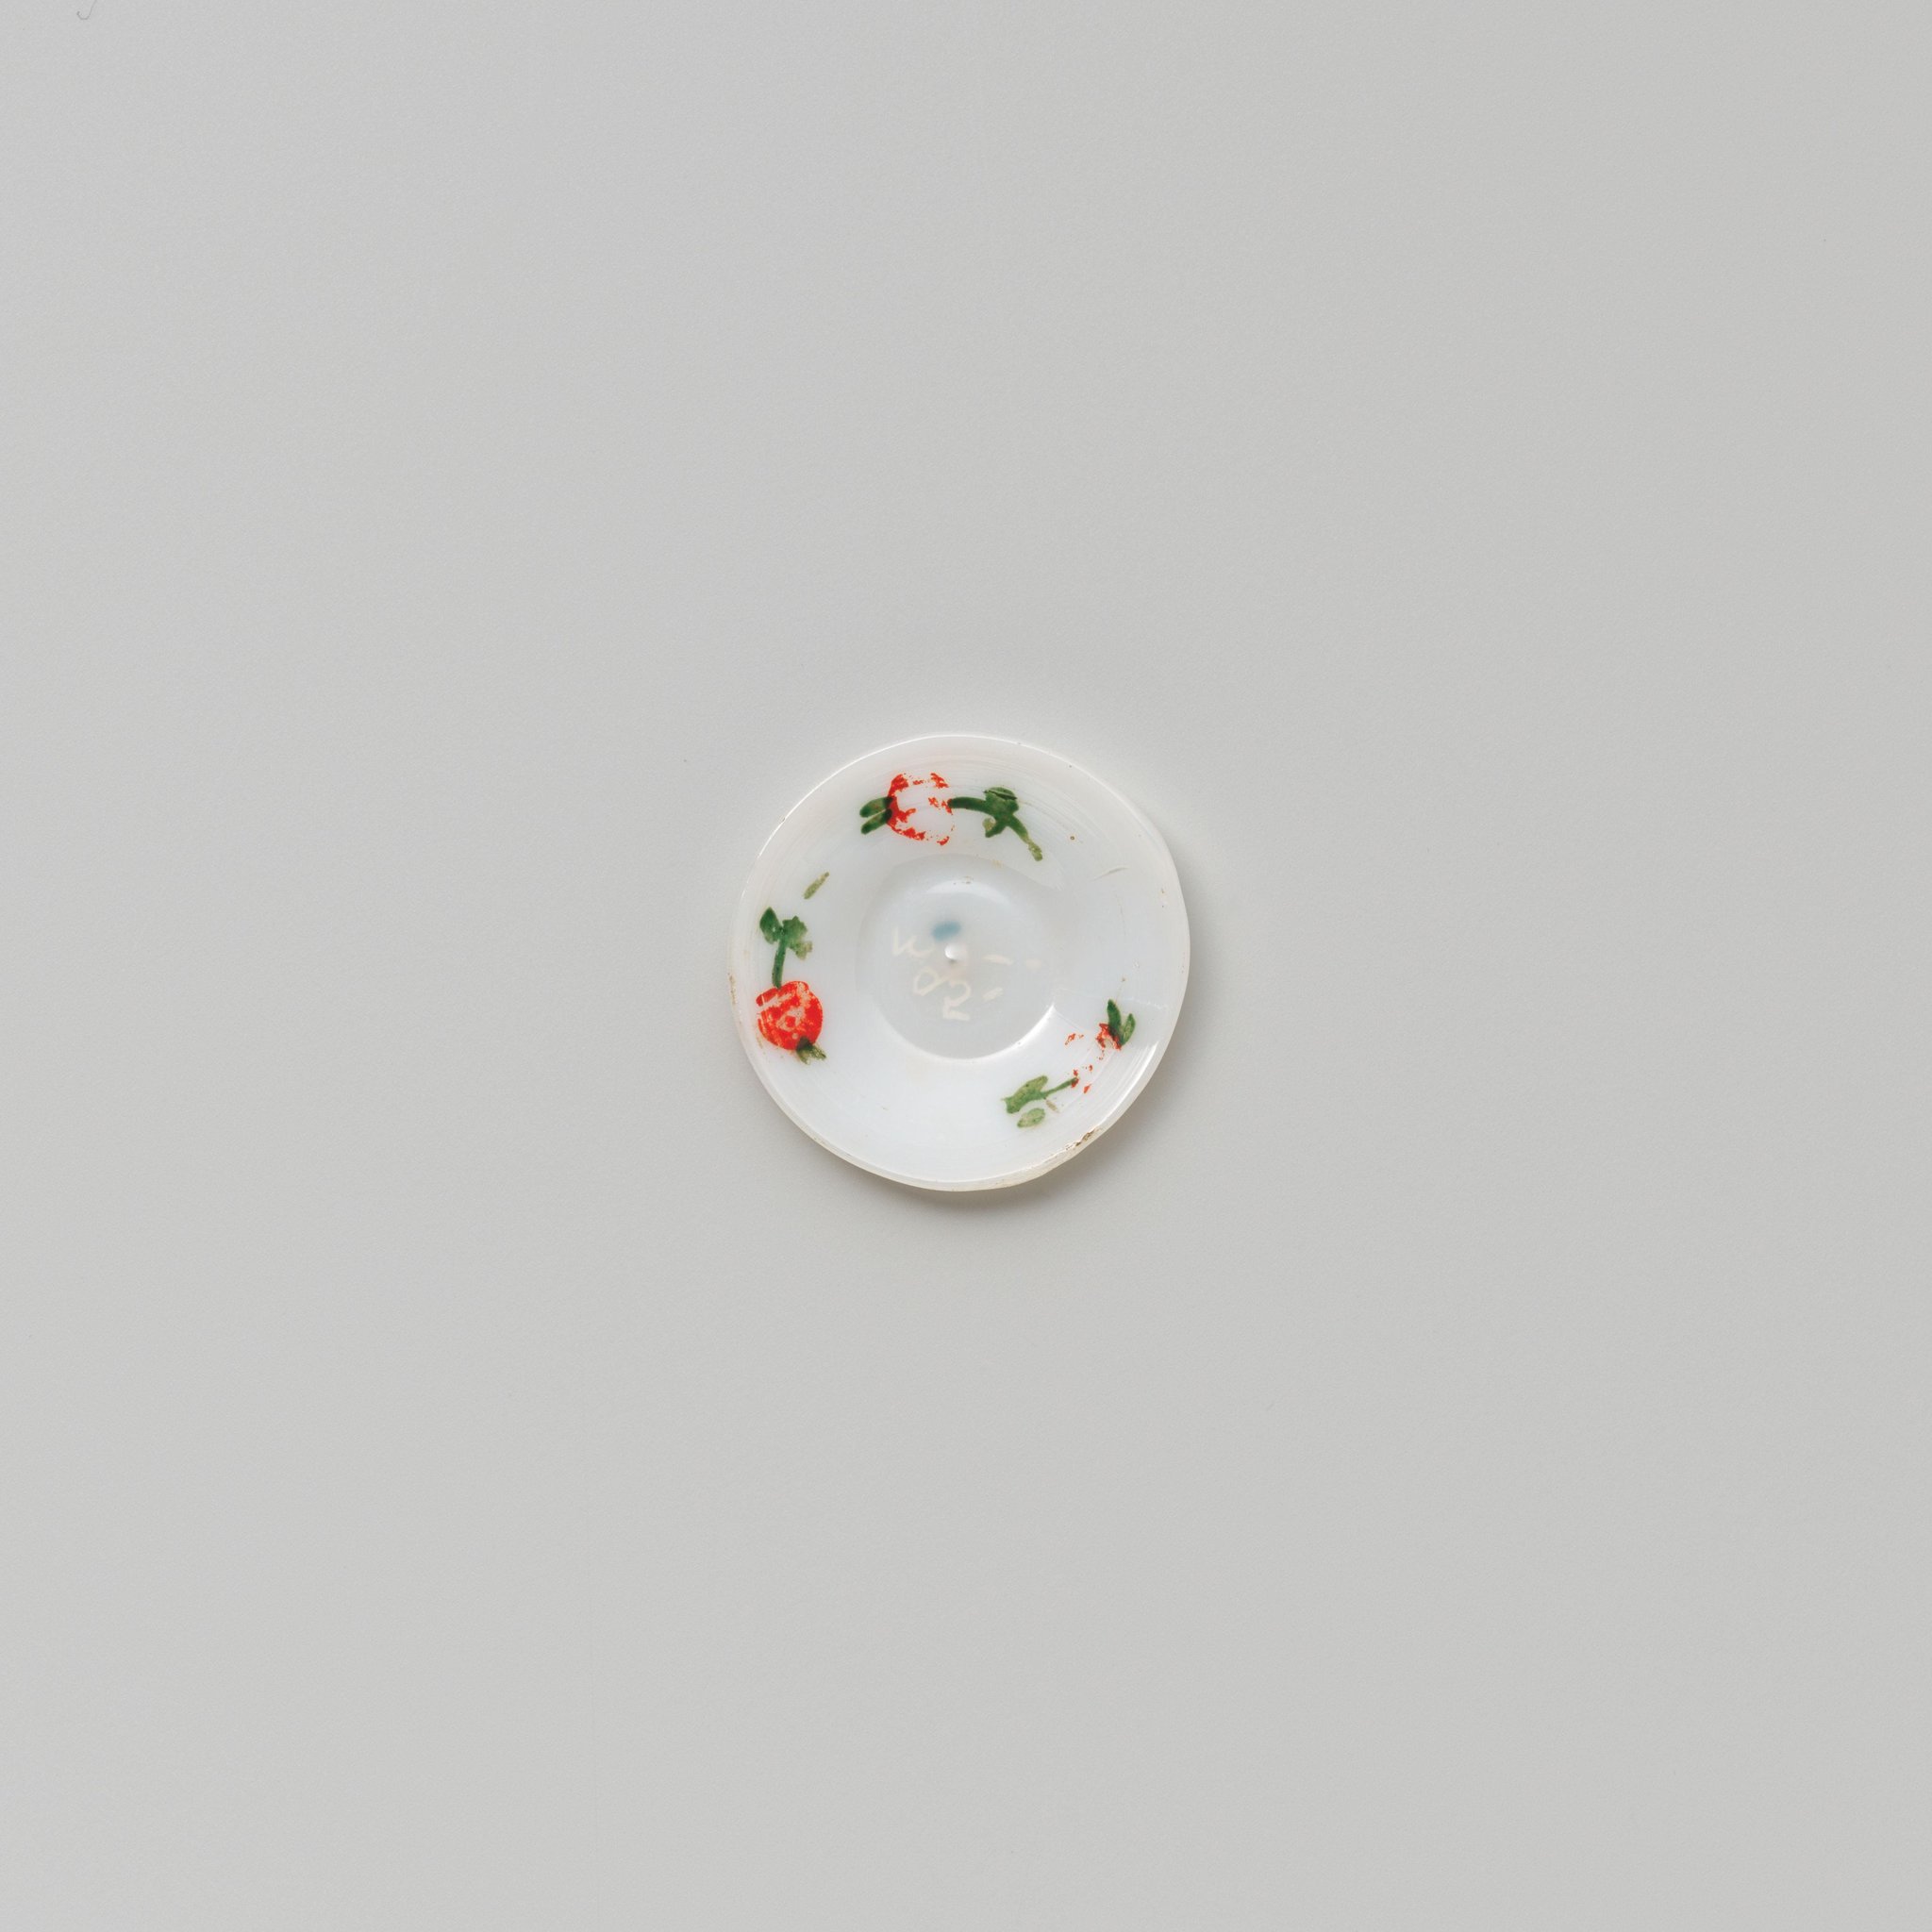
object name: platter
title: Schotel, beschilderd met bloemen in wit, groen en rood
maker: Anonymous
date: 1800-1849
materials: glass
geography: bristol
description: Schotel van opaak wit glas, met brede schuin opstaande rand, beschilderd met bloemenin wit, groen en rood.